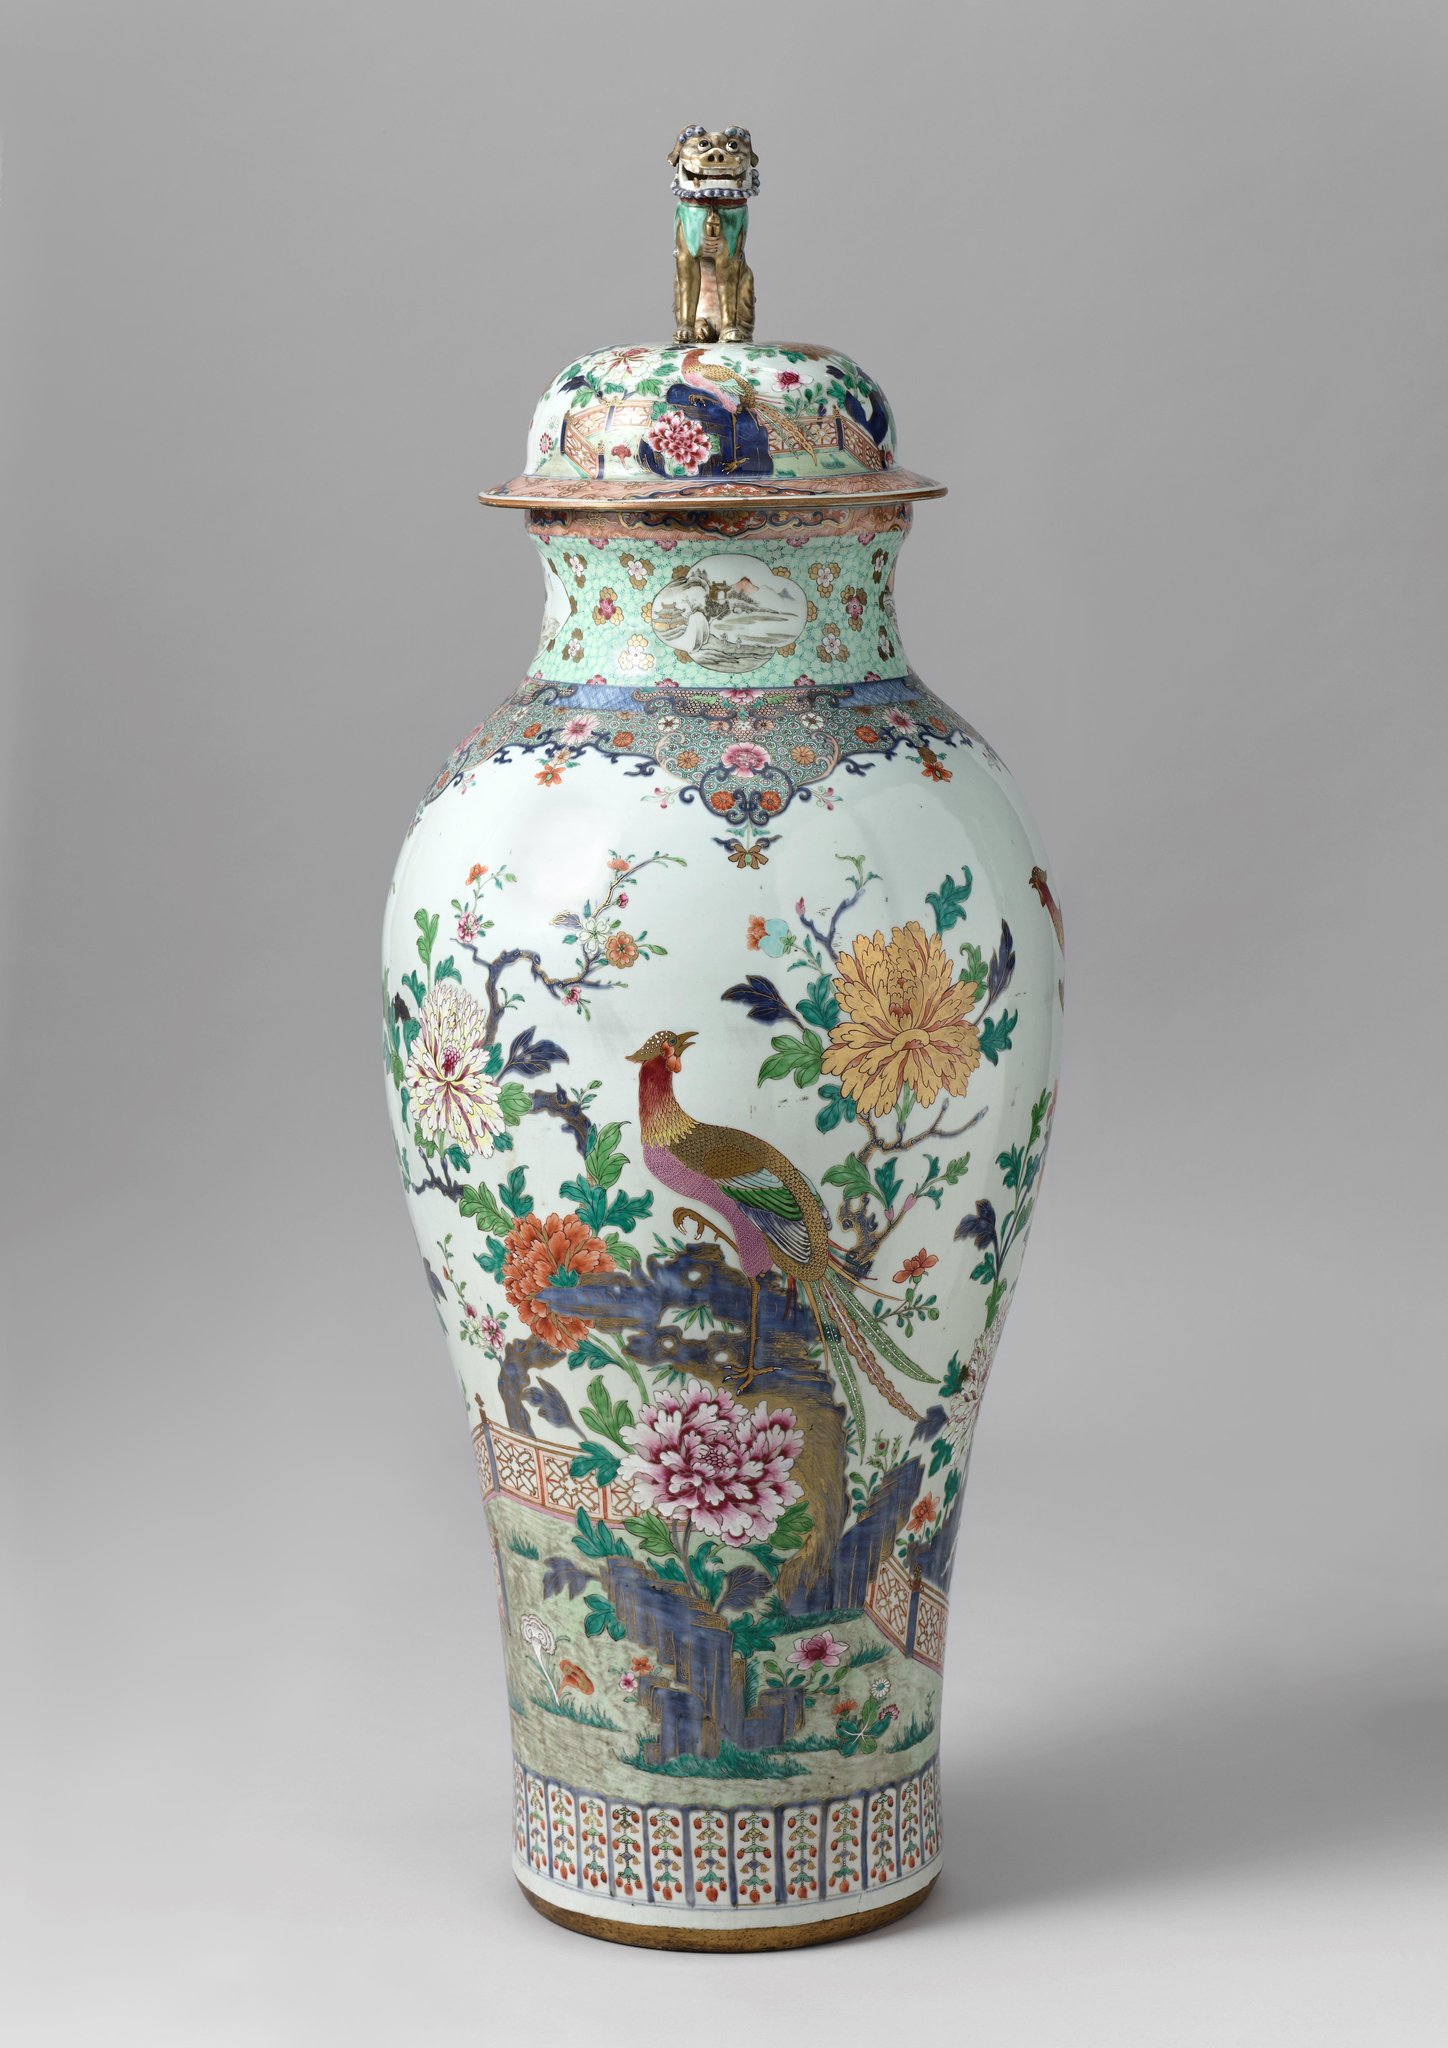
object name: lid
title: Two Lidded Vases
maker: Anonymous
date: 1750-1780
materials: cobalt, glaze, gold, paint, porcelain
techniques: firing, gilding, turning, vitrification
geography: china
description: Deksel van porselein, beschilderd in onderglazuur blauw en op het glazuur in blauw, rood, roze, groen, geel, zwart en goud. Op de wand een fazant op een rots bij bloeiende planten (pioen, prunus) en een hek. In de lucht vliegt een tweede fazant, vlinders en vogels. Op de grond andere bloemen (aster, lotus, prachtanjer), paddenstoelen (lingzhi) en een vijver met eenden. Op de schouder een decoratieve band van kleine bloemrozetten met daarop krulwerk en losse bloemen. Boven de voet een band met gestileerde bladmotieven gevuld met slingers met gelukssymbolen (muzieksteen, munt, ruit). Op de nek een band met 'crackled ice' en prunusbloesems onderbroken door gelobde cartouches met een landschap in ence de Chine. De buitenrand in Imari-kleuren met een band met wolken op arceerwerk onderbroken door cartouches met lotusranken. Dekselknop in de vorm van een shishi. Famille rose.